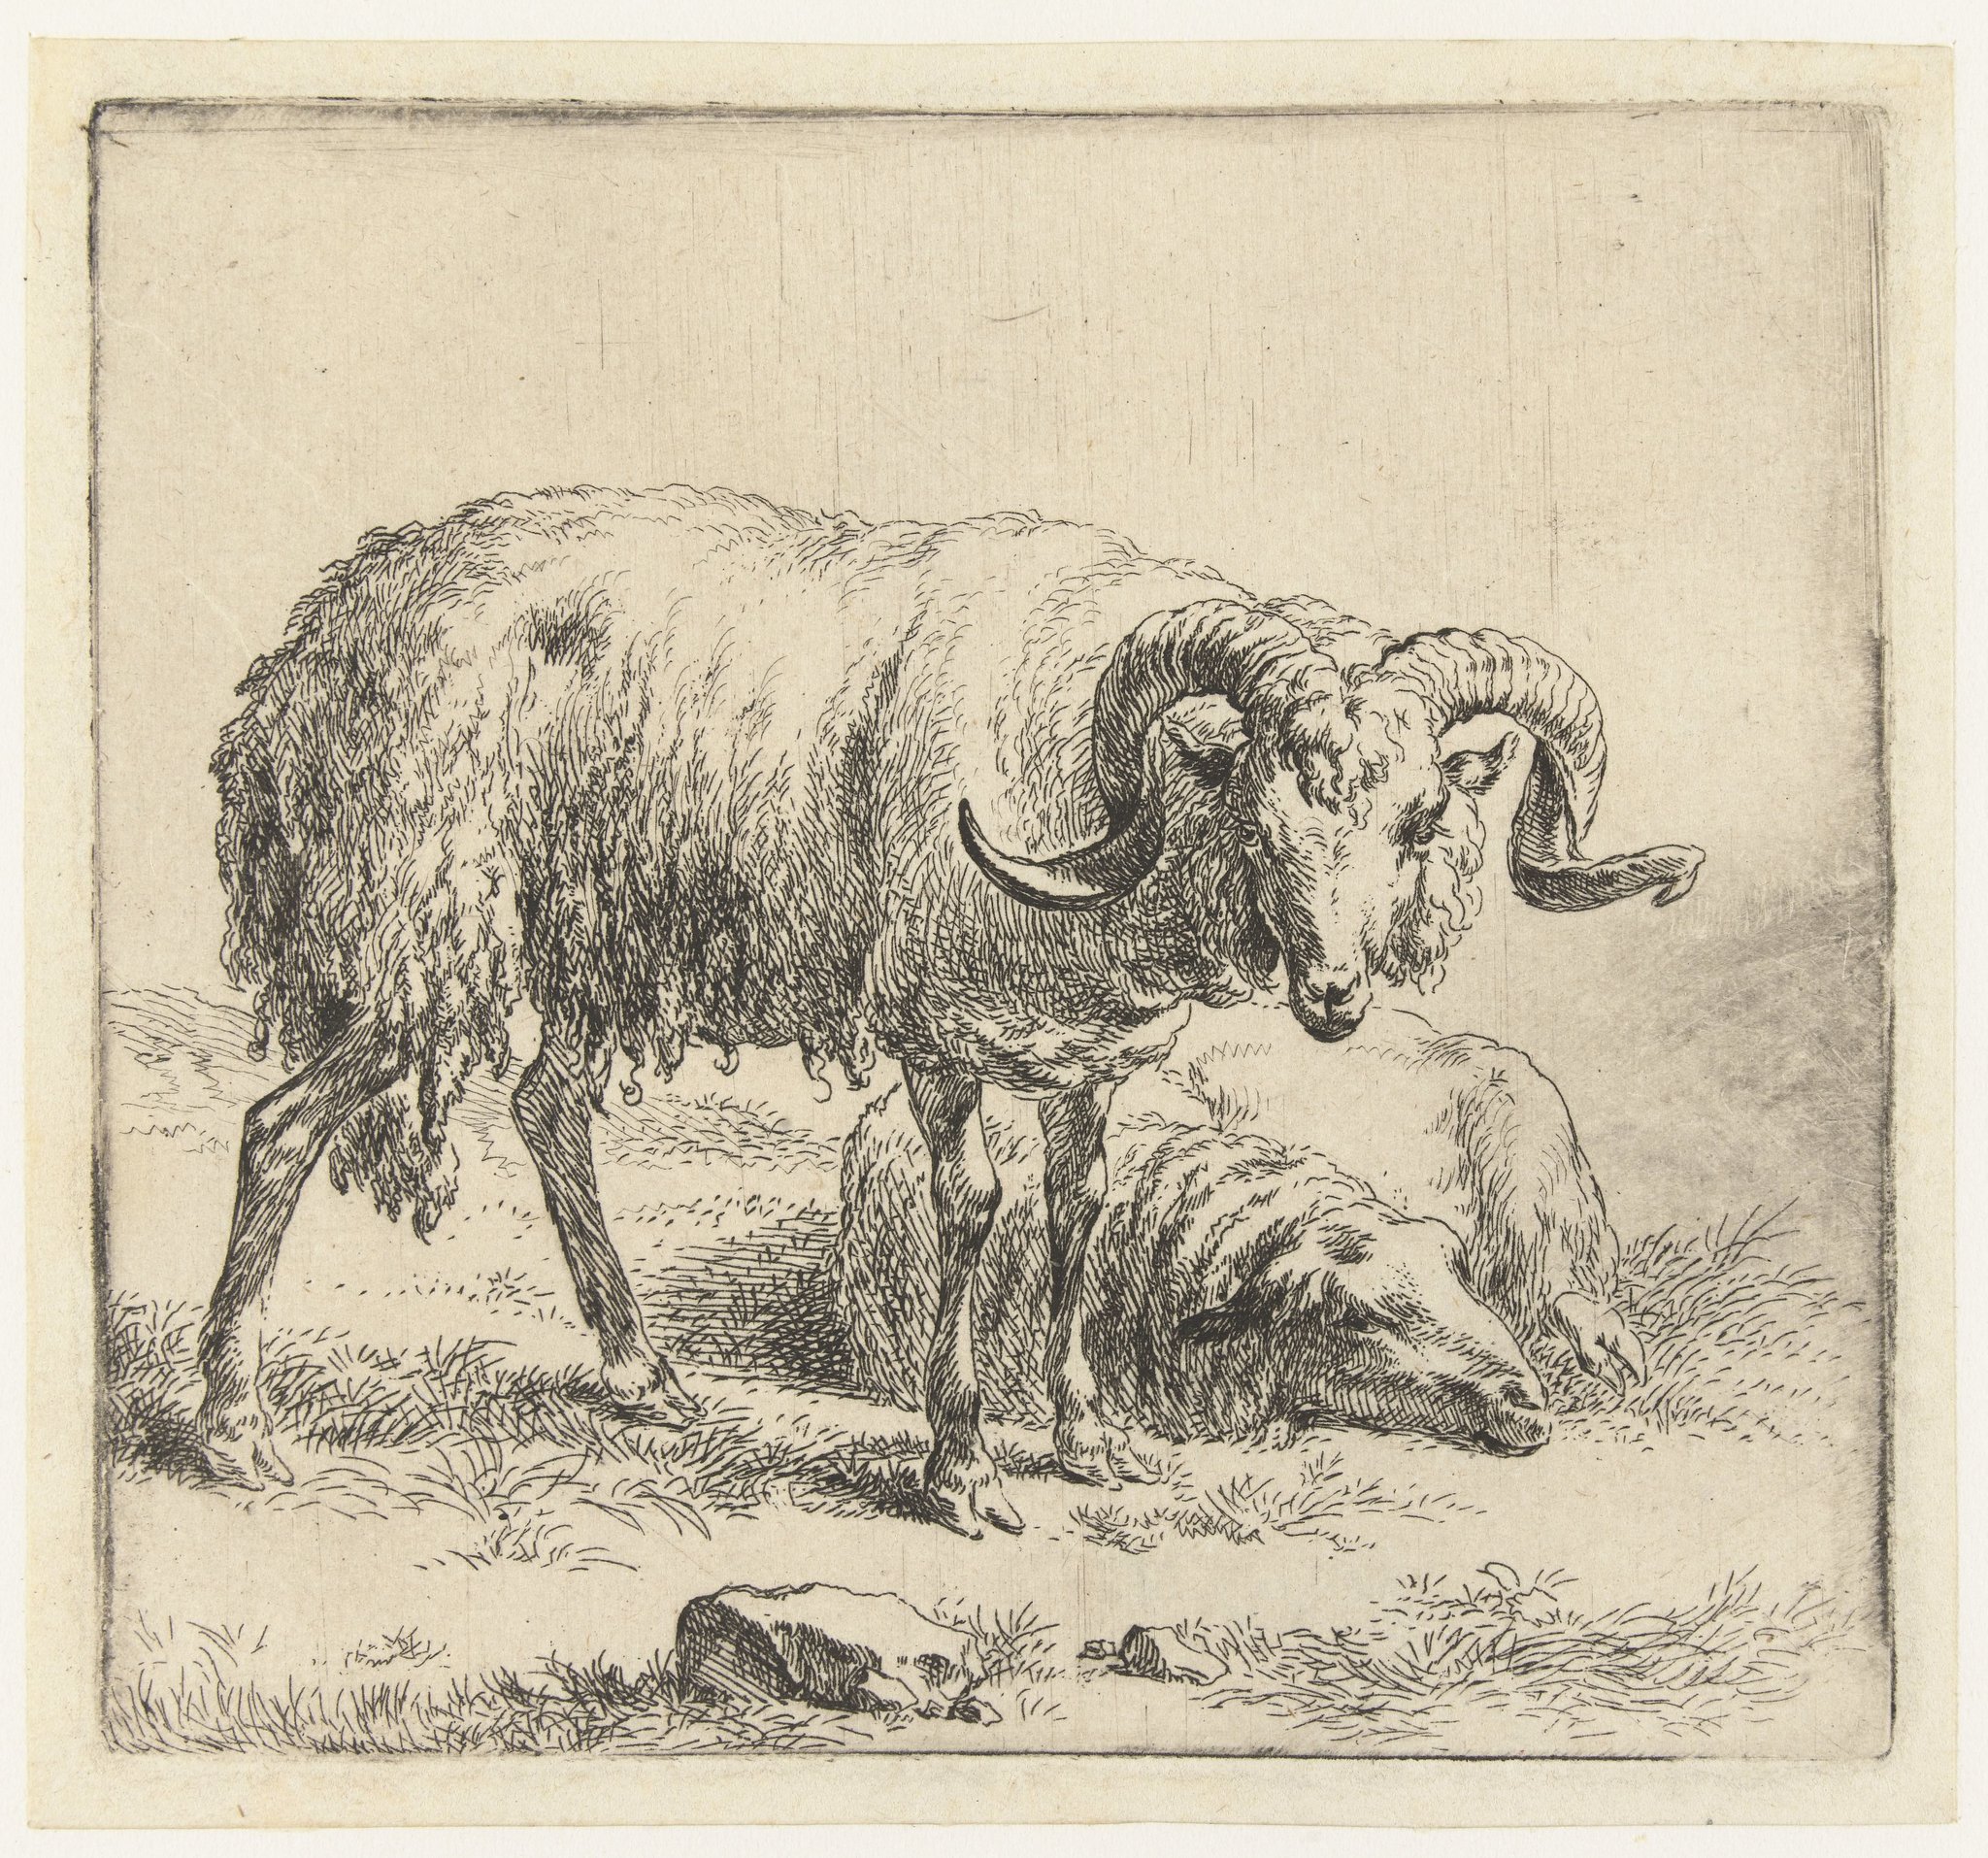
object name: print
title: Animalia ad vivum delineata et aqua forti aeri impressa Studio et Arte Nicolai Berchemi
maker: nicolaes pietersz berchem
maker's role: draughtsman, print maker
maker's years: 1620-1683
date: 1648-1652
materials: paper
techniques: etching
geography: netherlands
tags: sheep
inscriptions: collector's mark: Lugt 240